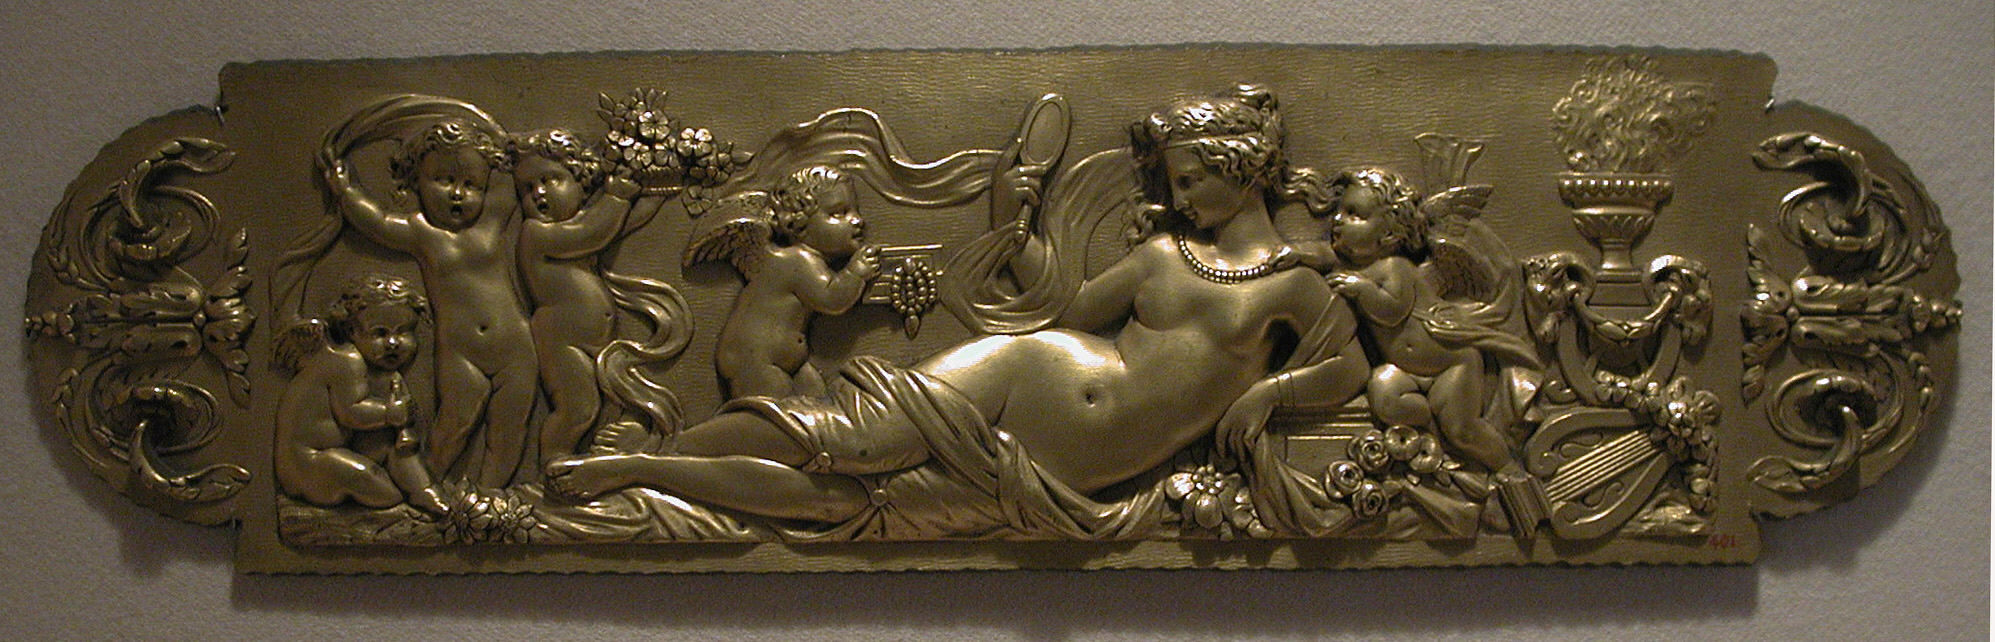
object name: panel ornament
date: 1834-1866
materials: gilt bronze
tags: male nudes,female nudes